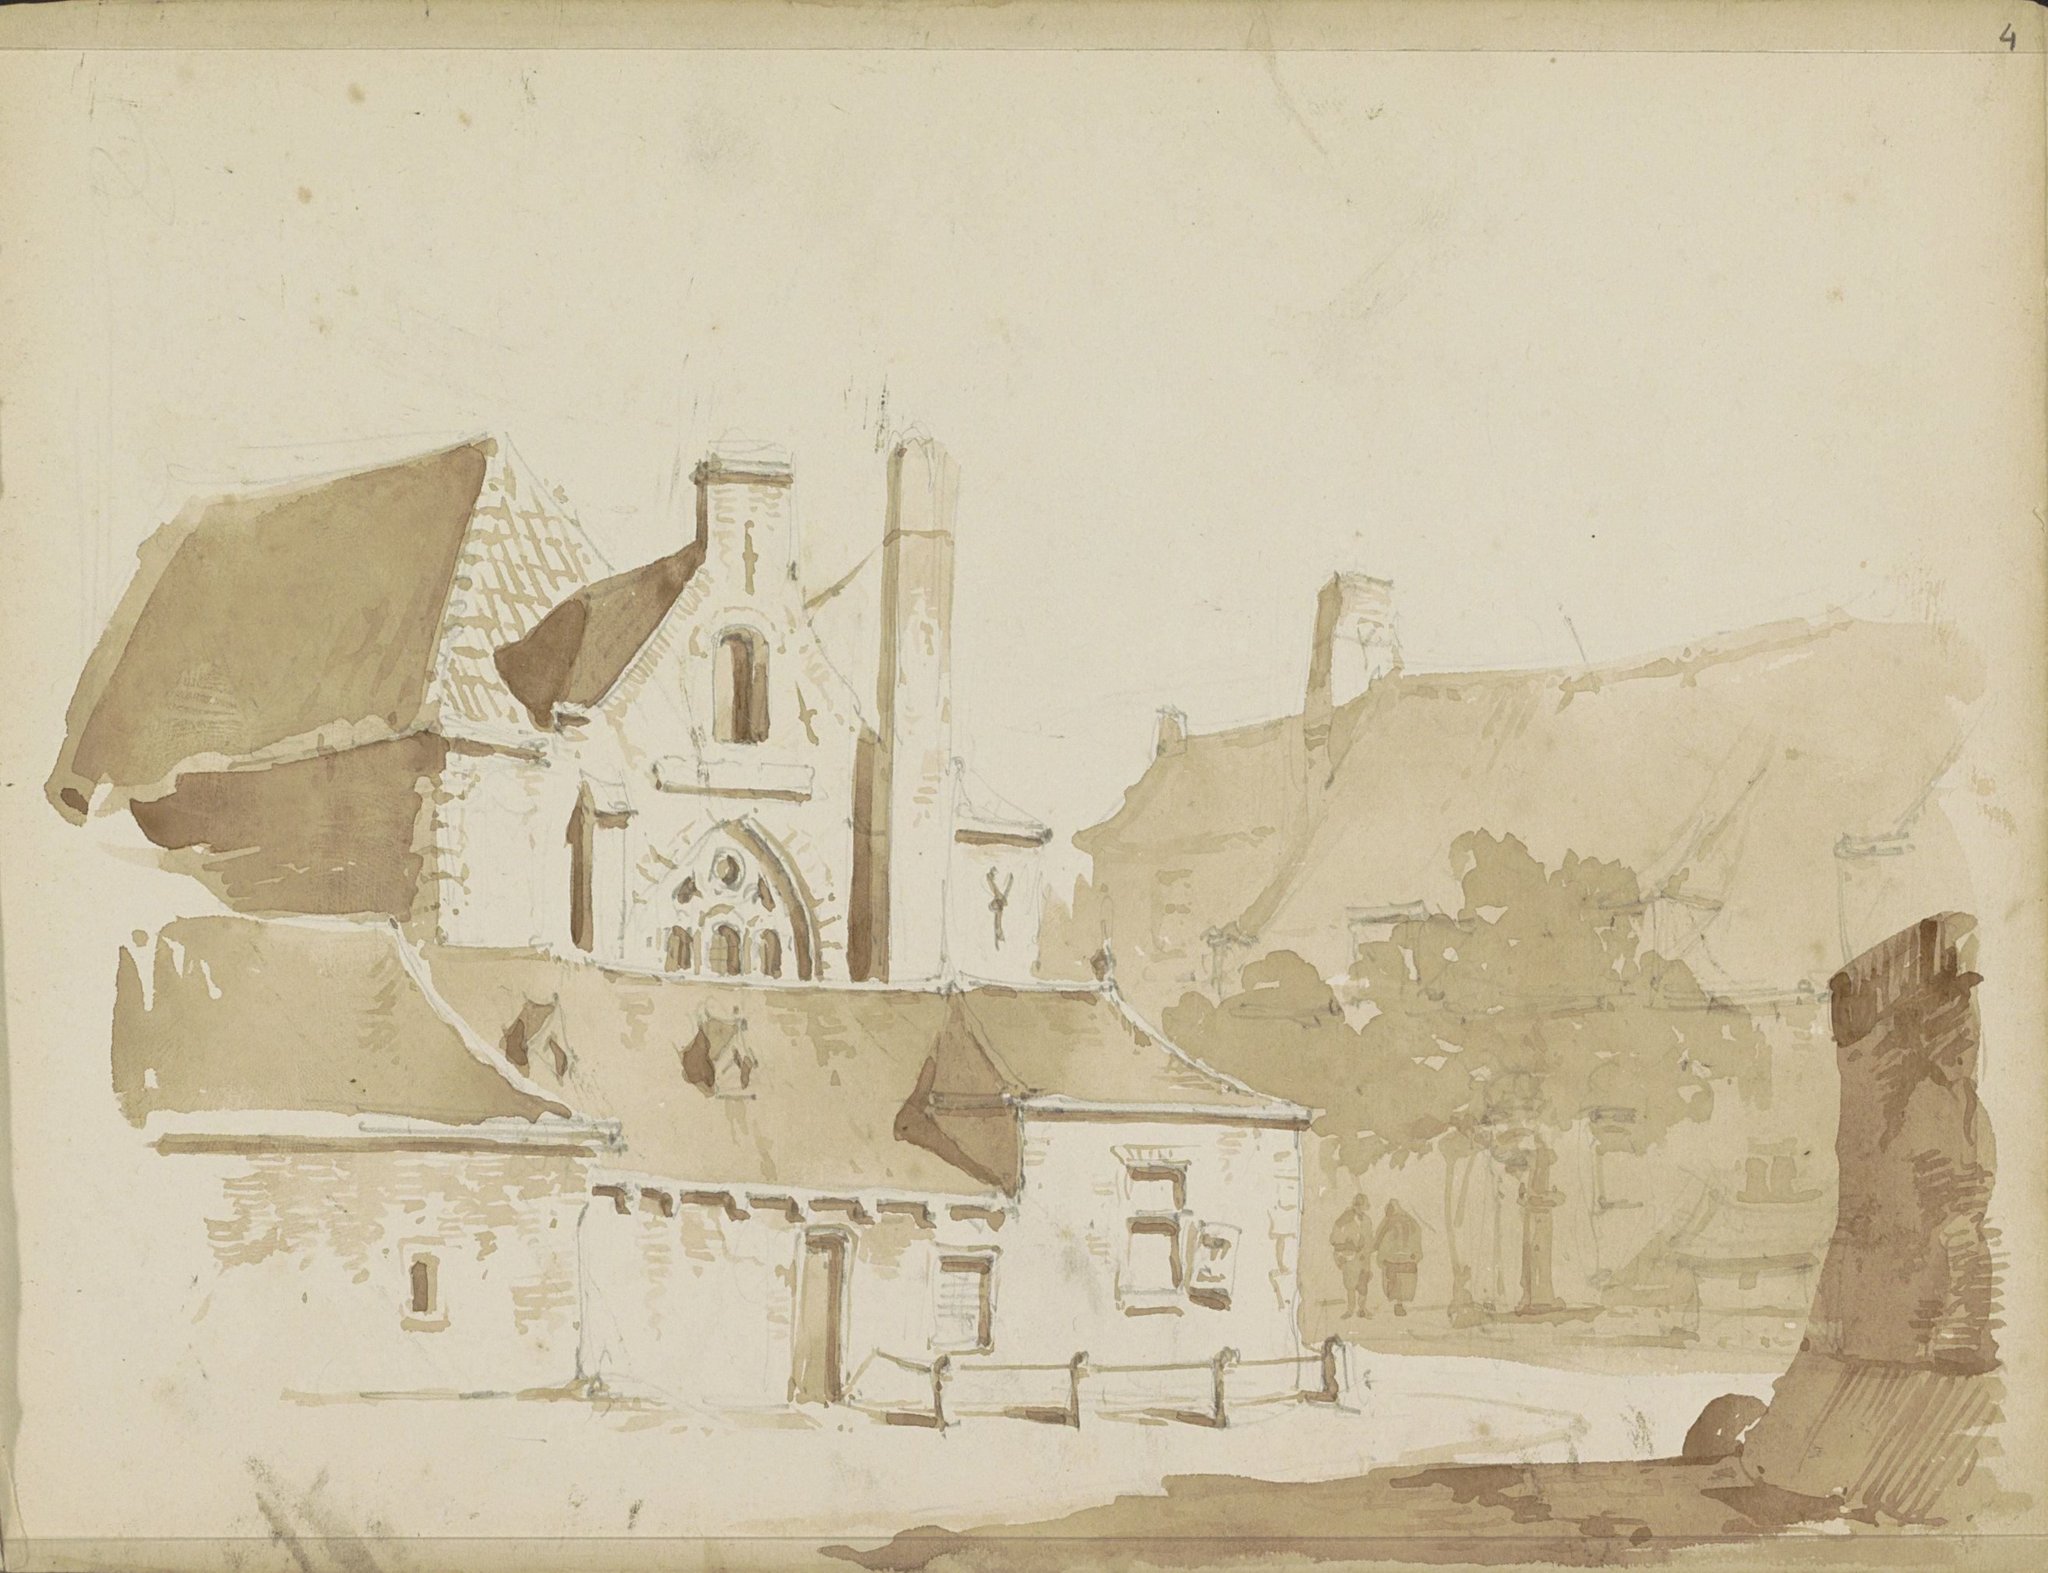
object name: sketchbook leaf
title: Stadsgezicht met een kerk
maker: adrianus eversen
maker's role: draughtsman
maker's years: 1818-1897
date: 1828-1897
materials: paper, pencil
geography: netherlands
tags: city-view, and landscape with man-made constructions, church (exterior)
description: Stadsgezicht met een kerk. Links een gebouw. Rechts twee figuren onder bomen voor een gebouw. Blad 4 recto uit een schetsboek met 41 bladen.